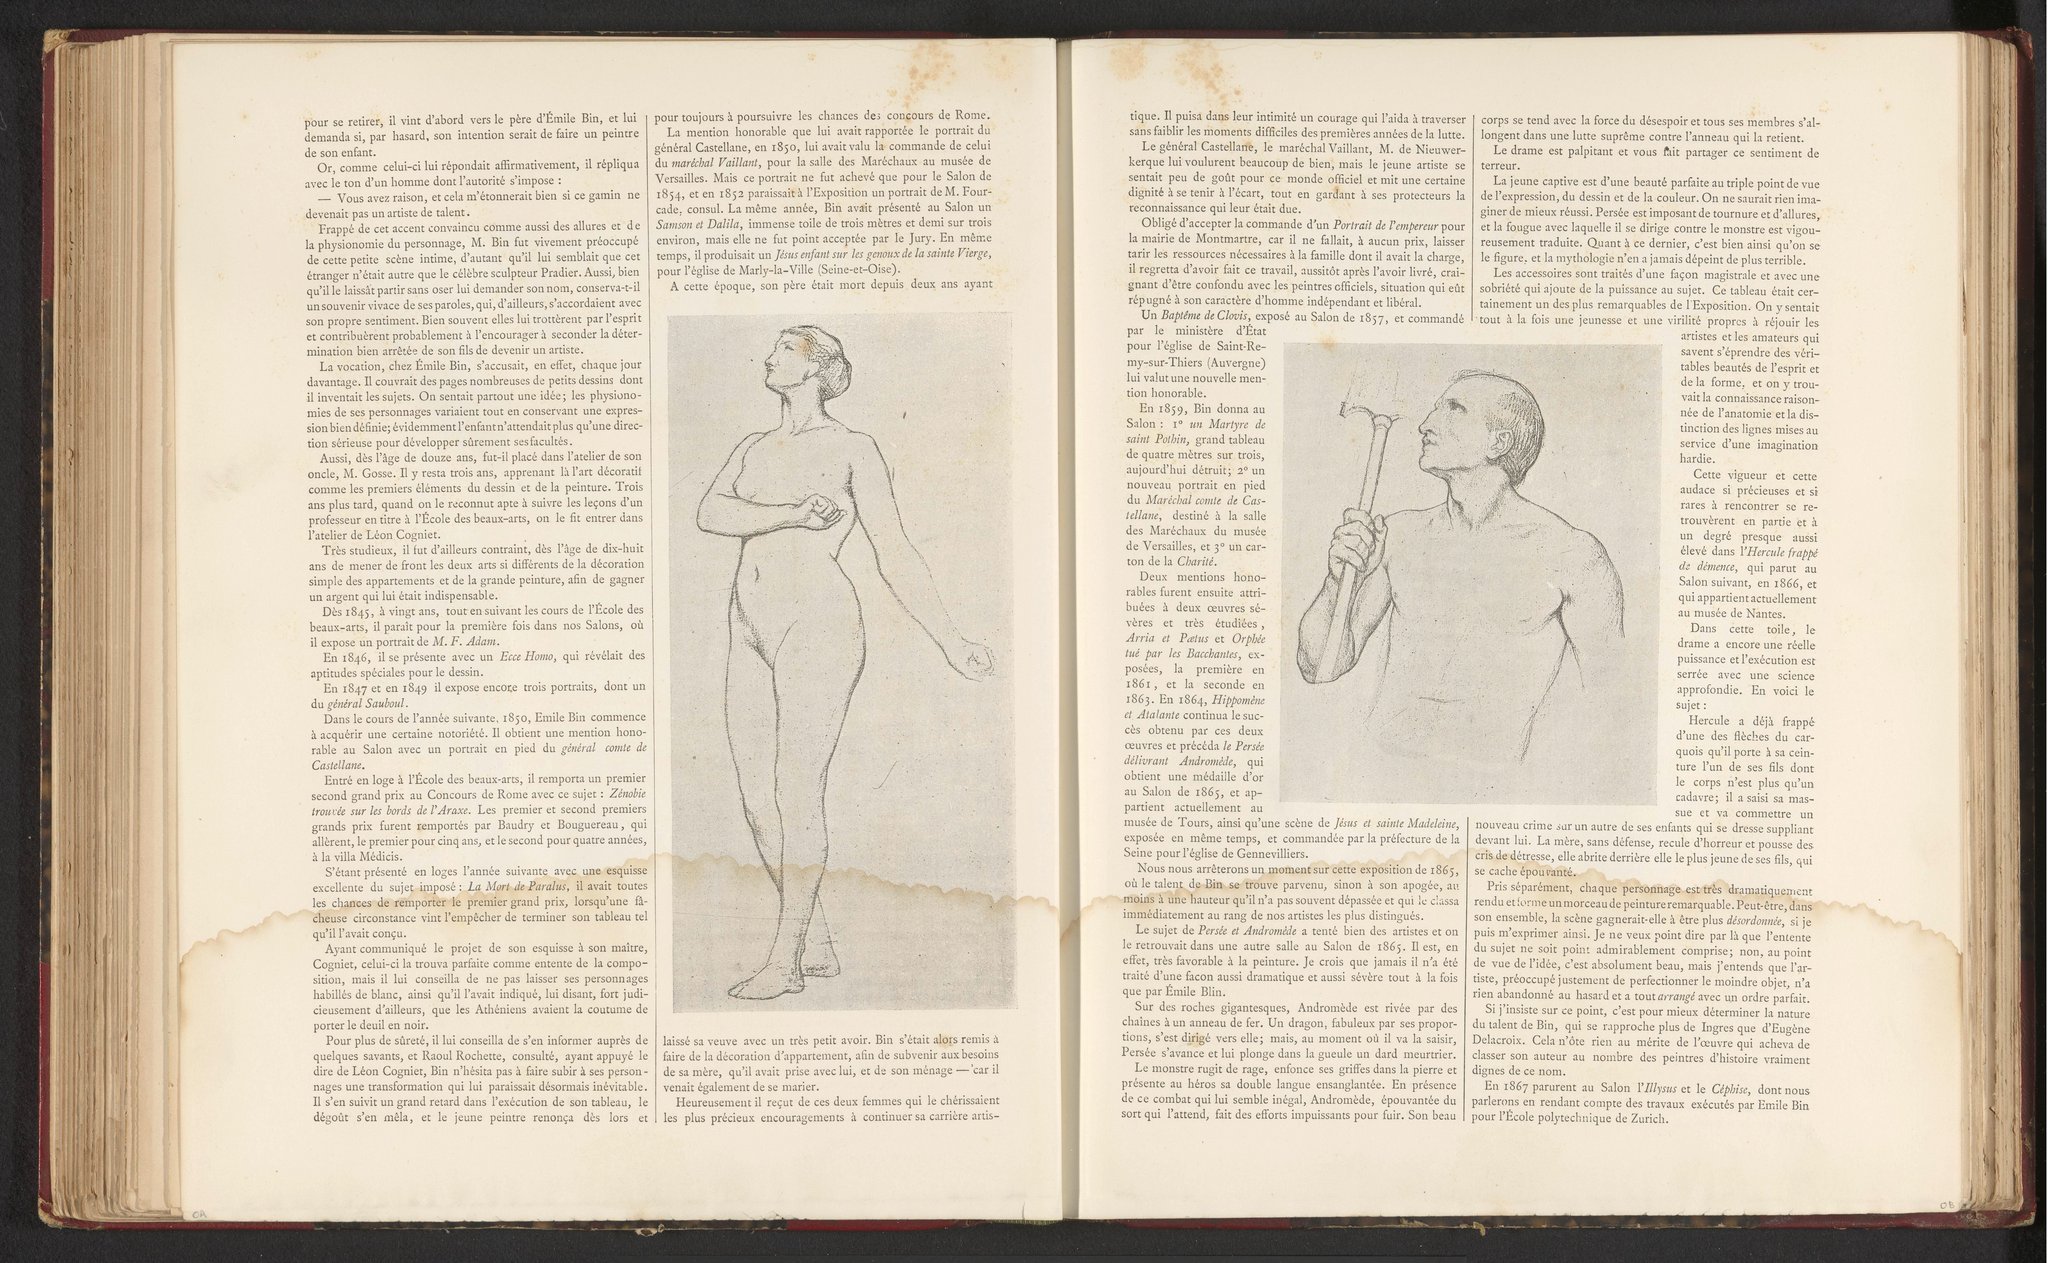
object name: reproduction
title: Fotoreproductie van een tekening door vermoedelijk Émile Bin, voorstellend een vrouwelijk naakt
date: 1876-1879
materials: paper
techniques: autotype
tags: drawing, sketch, the (nude) human figure; 'corpo humano' (ripa) - aa - female human figure